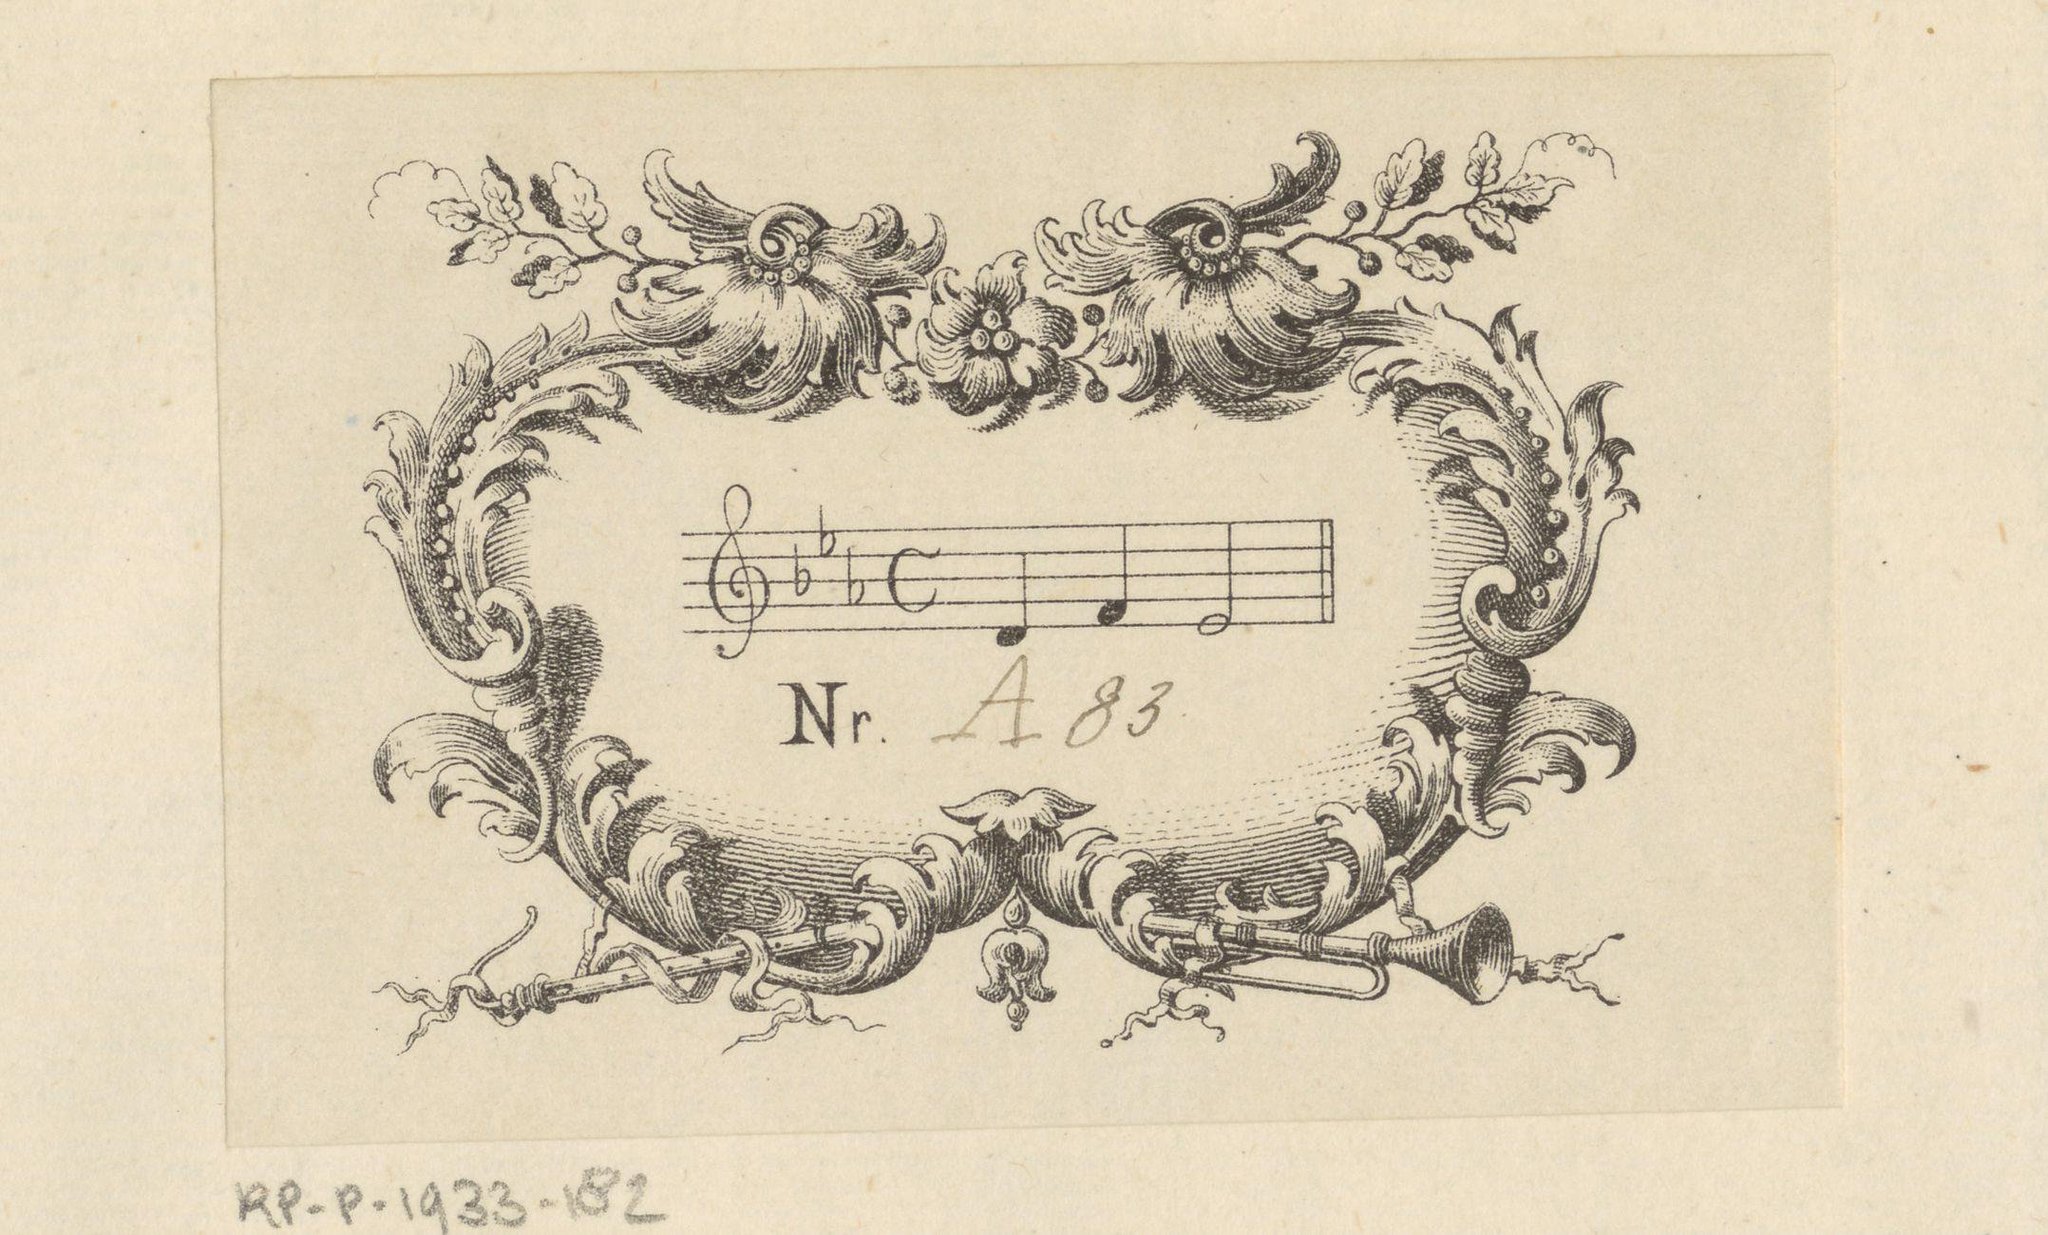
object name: bookplate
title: Ex libris van Daniël François Scheurleer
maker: Anonymous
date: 1855-1927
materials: paper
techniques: printing block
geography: netherlands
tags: the hague, daniël françois scheurleer, notation of music, ornament ~ festoon, garland, flute, aulos, tibia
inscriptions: collector's mark: Lugt 2760